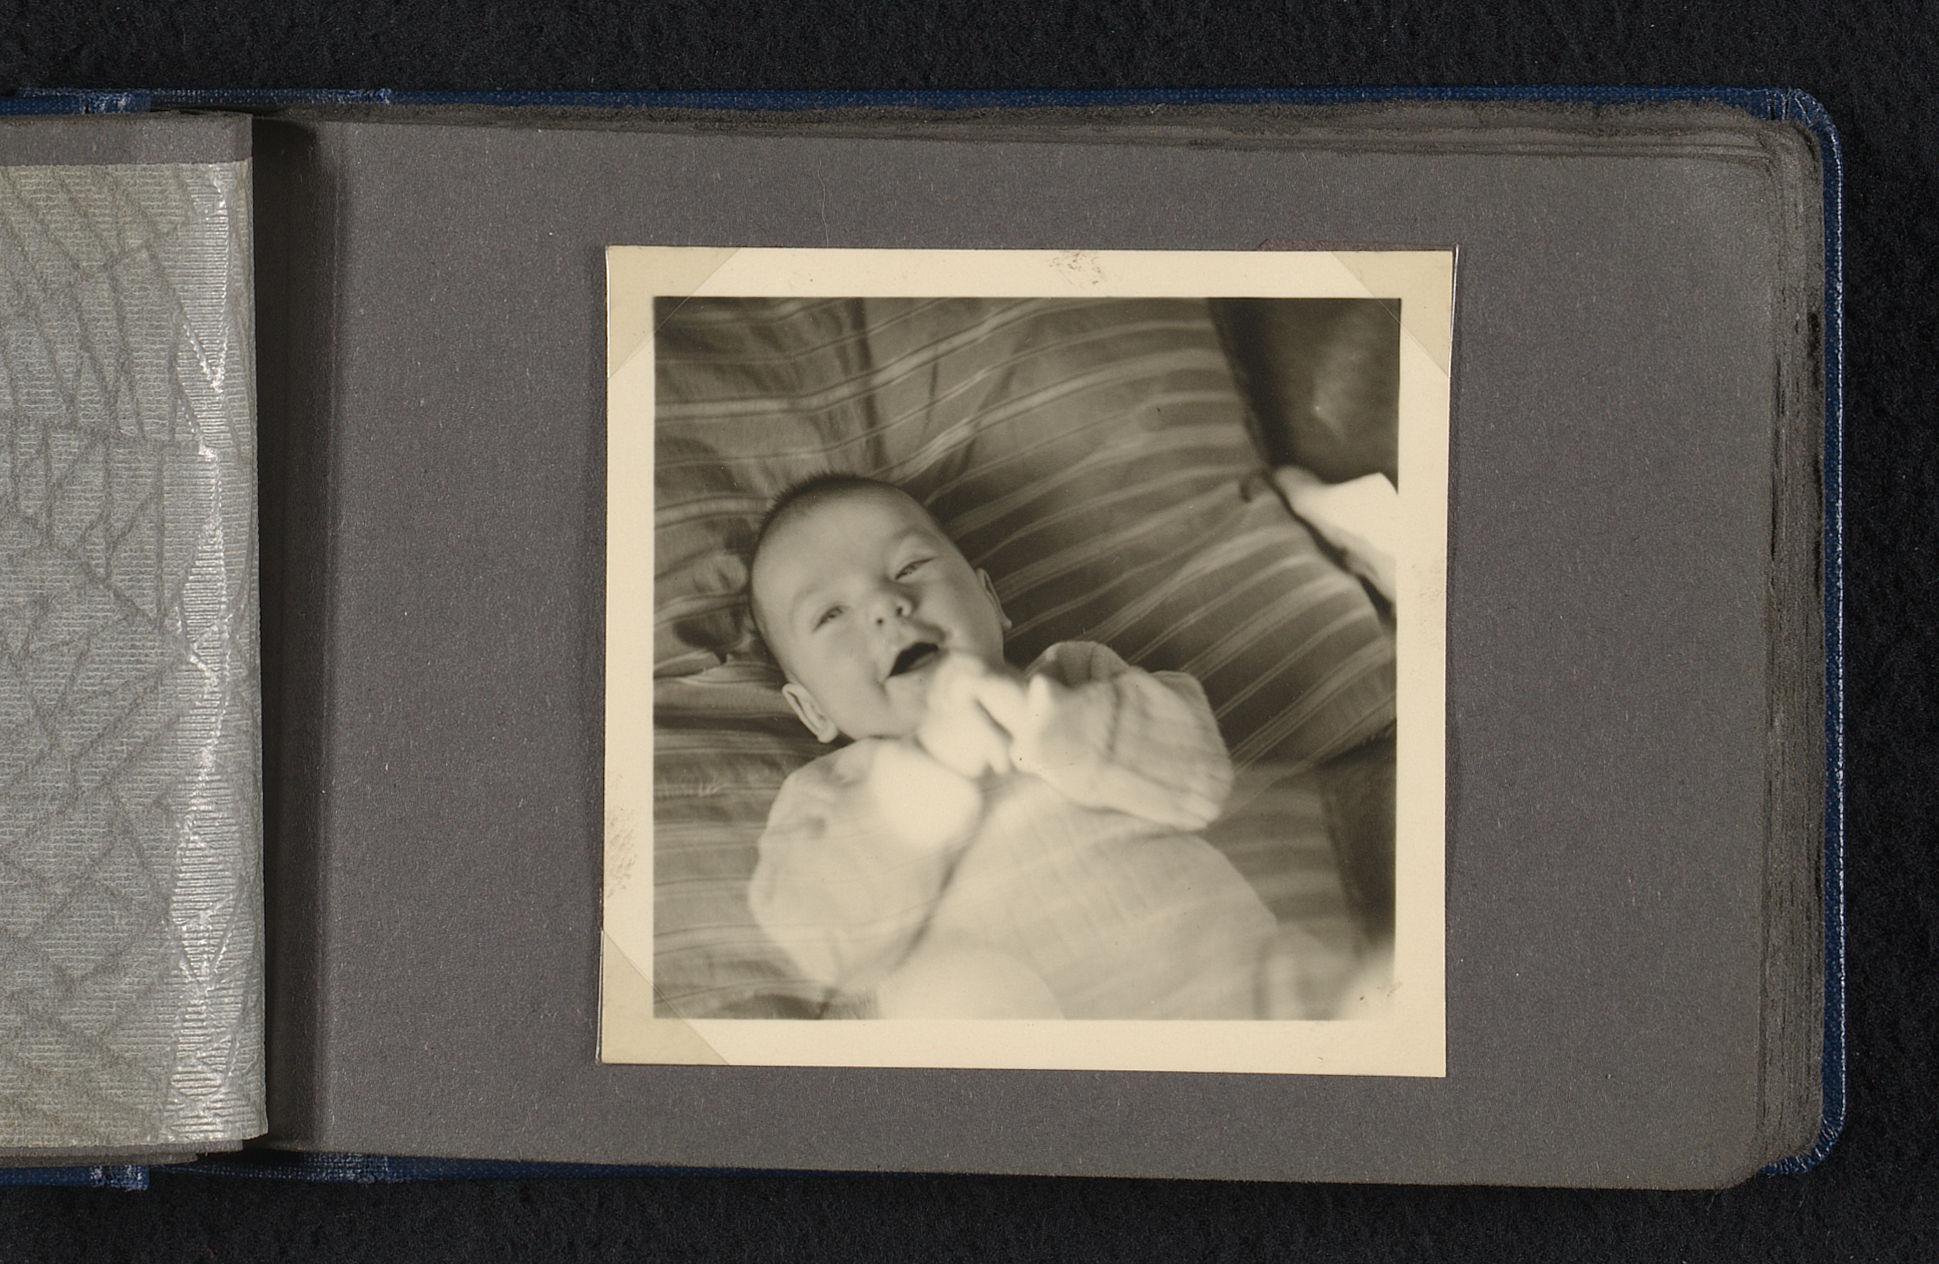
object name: photograph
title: Portret van een lachende Norbert Peter van den Berg als baby, liggend op een kussen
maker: norbert peter van den berg (1941-)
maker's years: 1941-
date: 1941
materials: paper, cardboard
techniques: gelatin silver print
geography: netherlands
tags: amsterdam, norbert peter van den berg (1941-), smiling, pillow, infant, baby